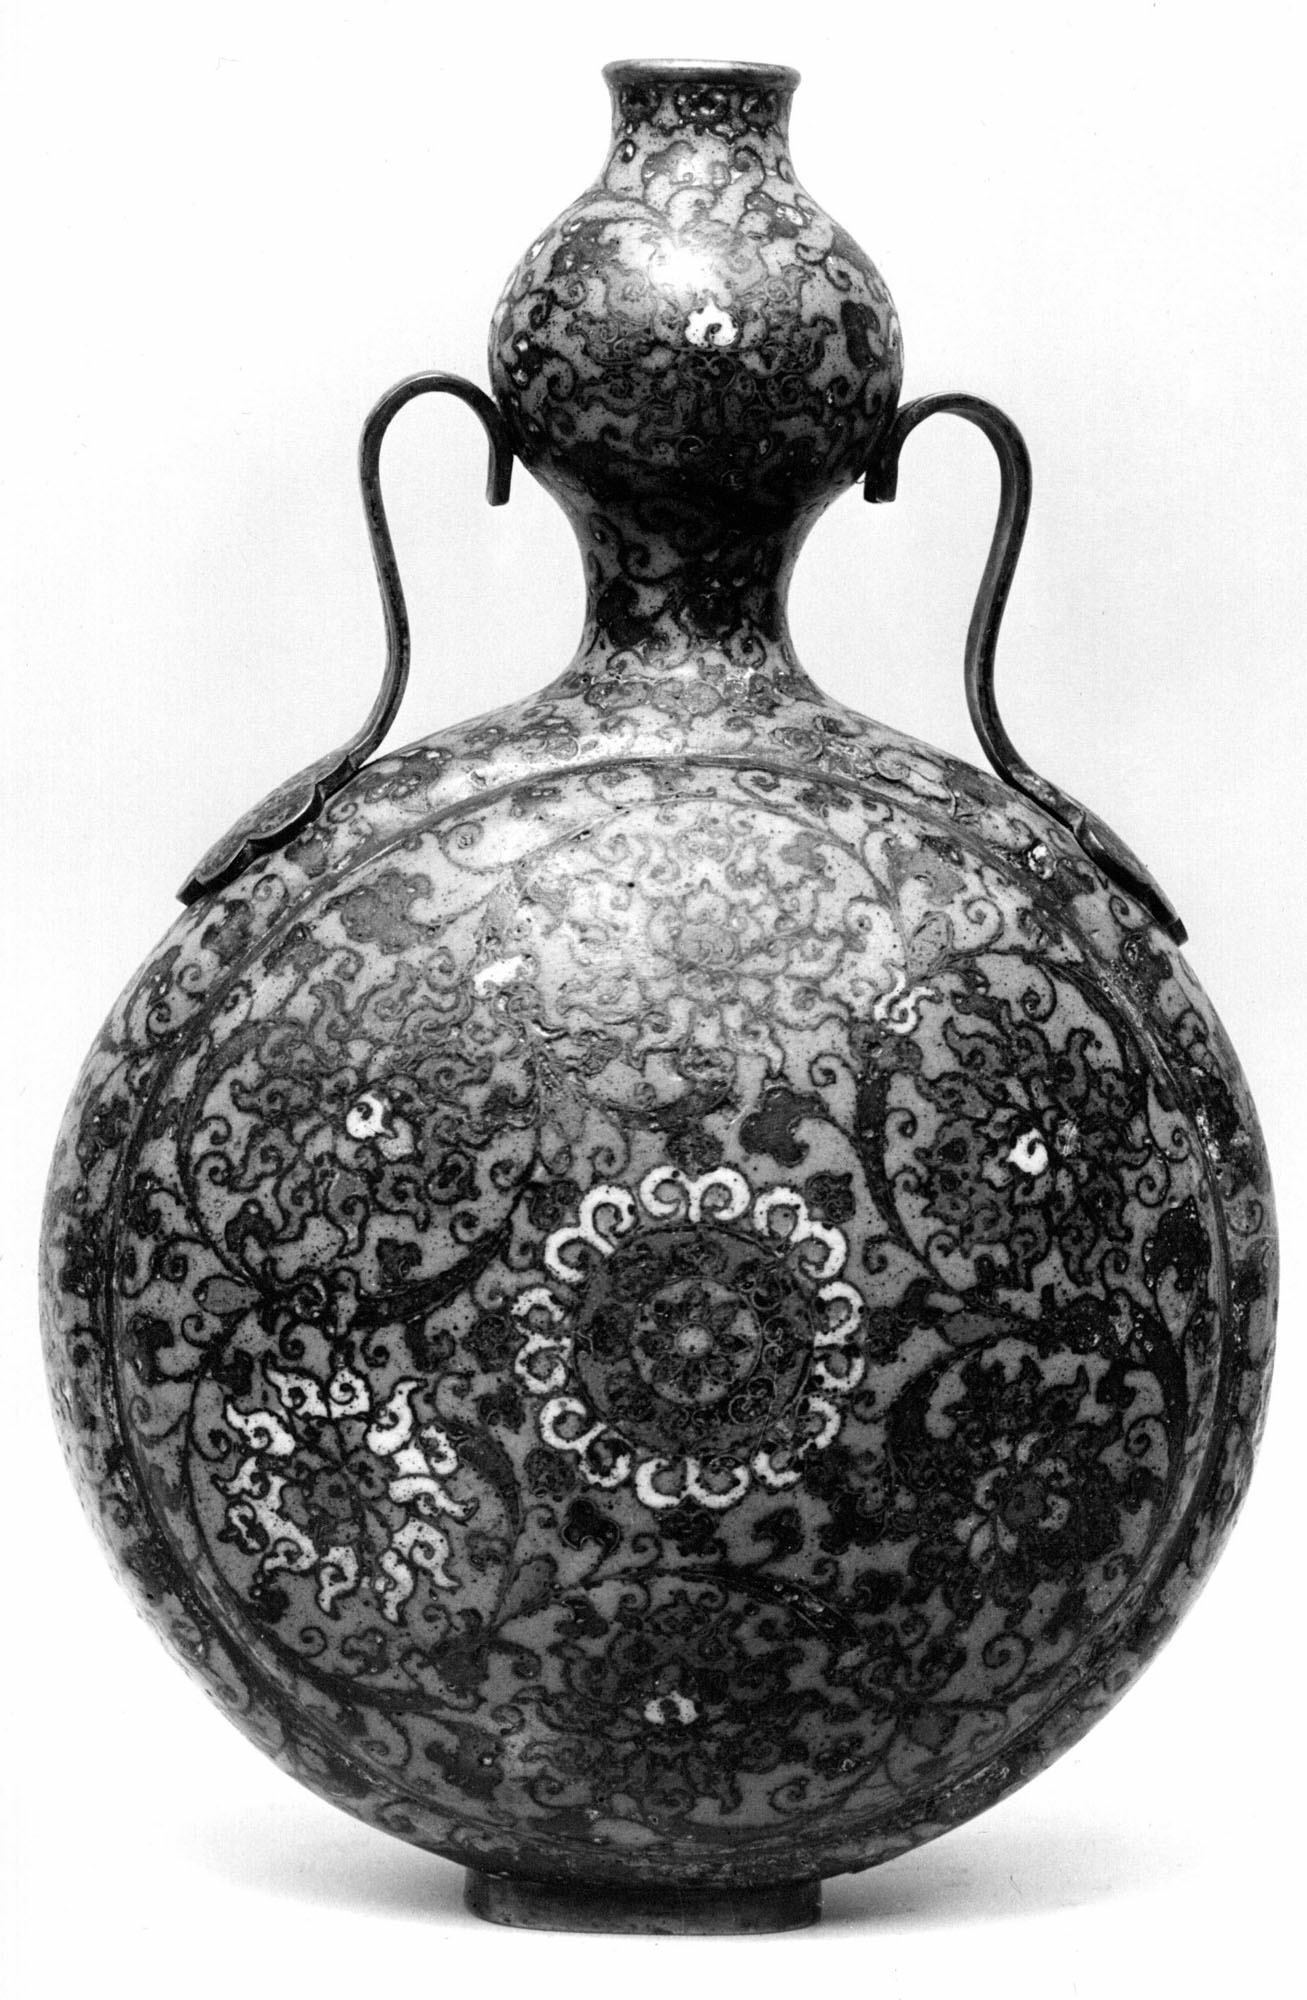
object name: pilgrim bottle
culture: chinese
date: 1567-1633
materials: enamel, copper gilt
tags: flowers